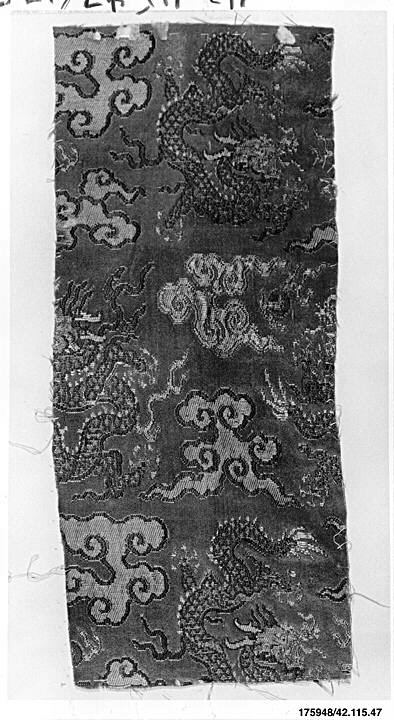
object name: piece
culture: chinese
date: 1701-1733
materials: metal thread, silk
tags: dragons,clouds